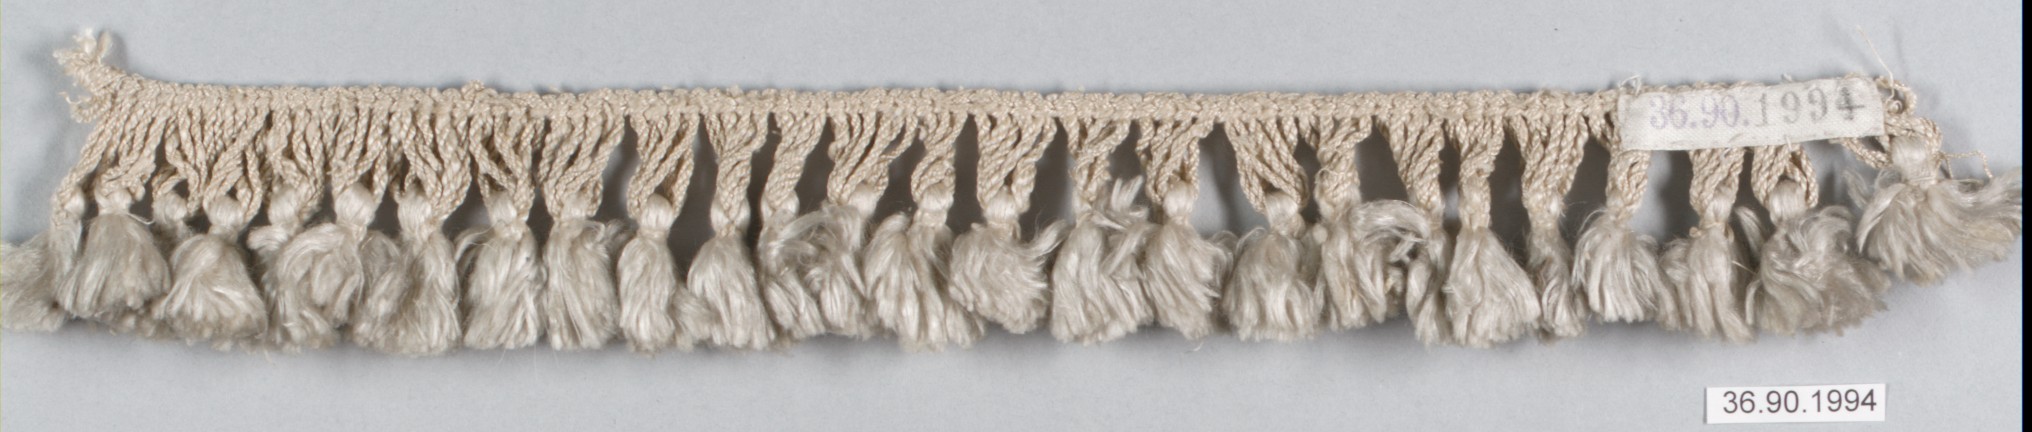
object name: fringe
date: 1700